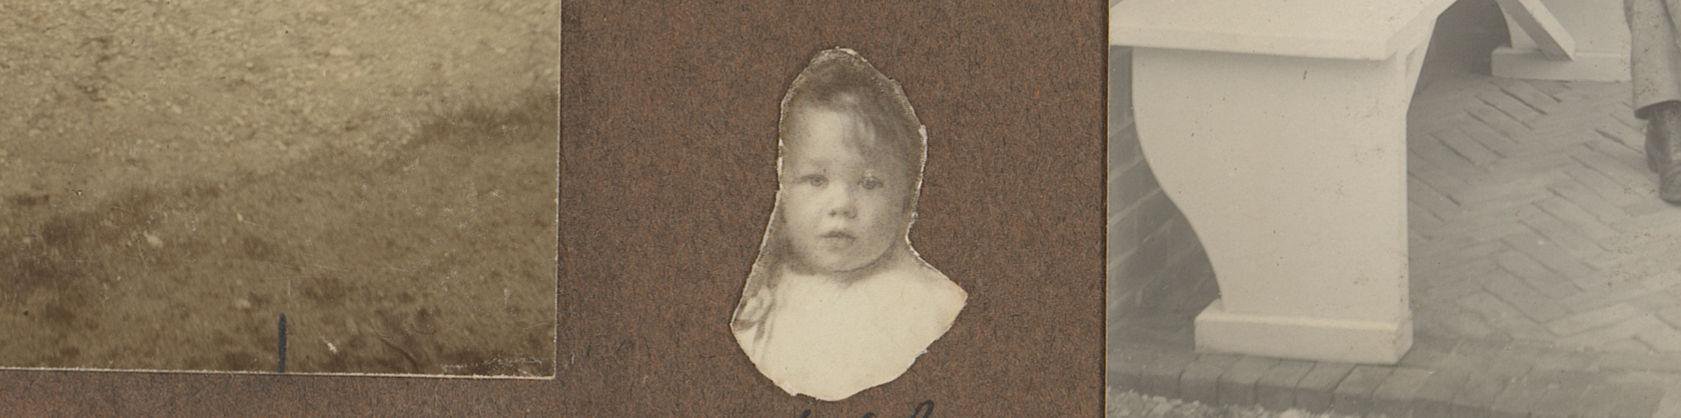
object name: photograph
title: Alphons Diepenbrock wandelend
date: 1911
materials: photographic support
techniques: photography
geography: netherlands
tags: alphons diepenbrock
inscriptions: date: ‘1906’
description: Foto op bruin albumblad 19 van familiealbum van Alphons Diepenbrock.